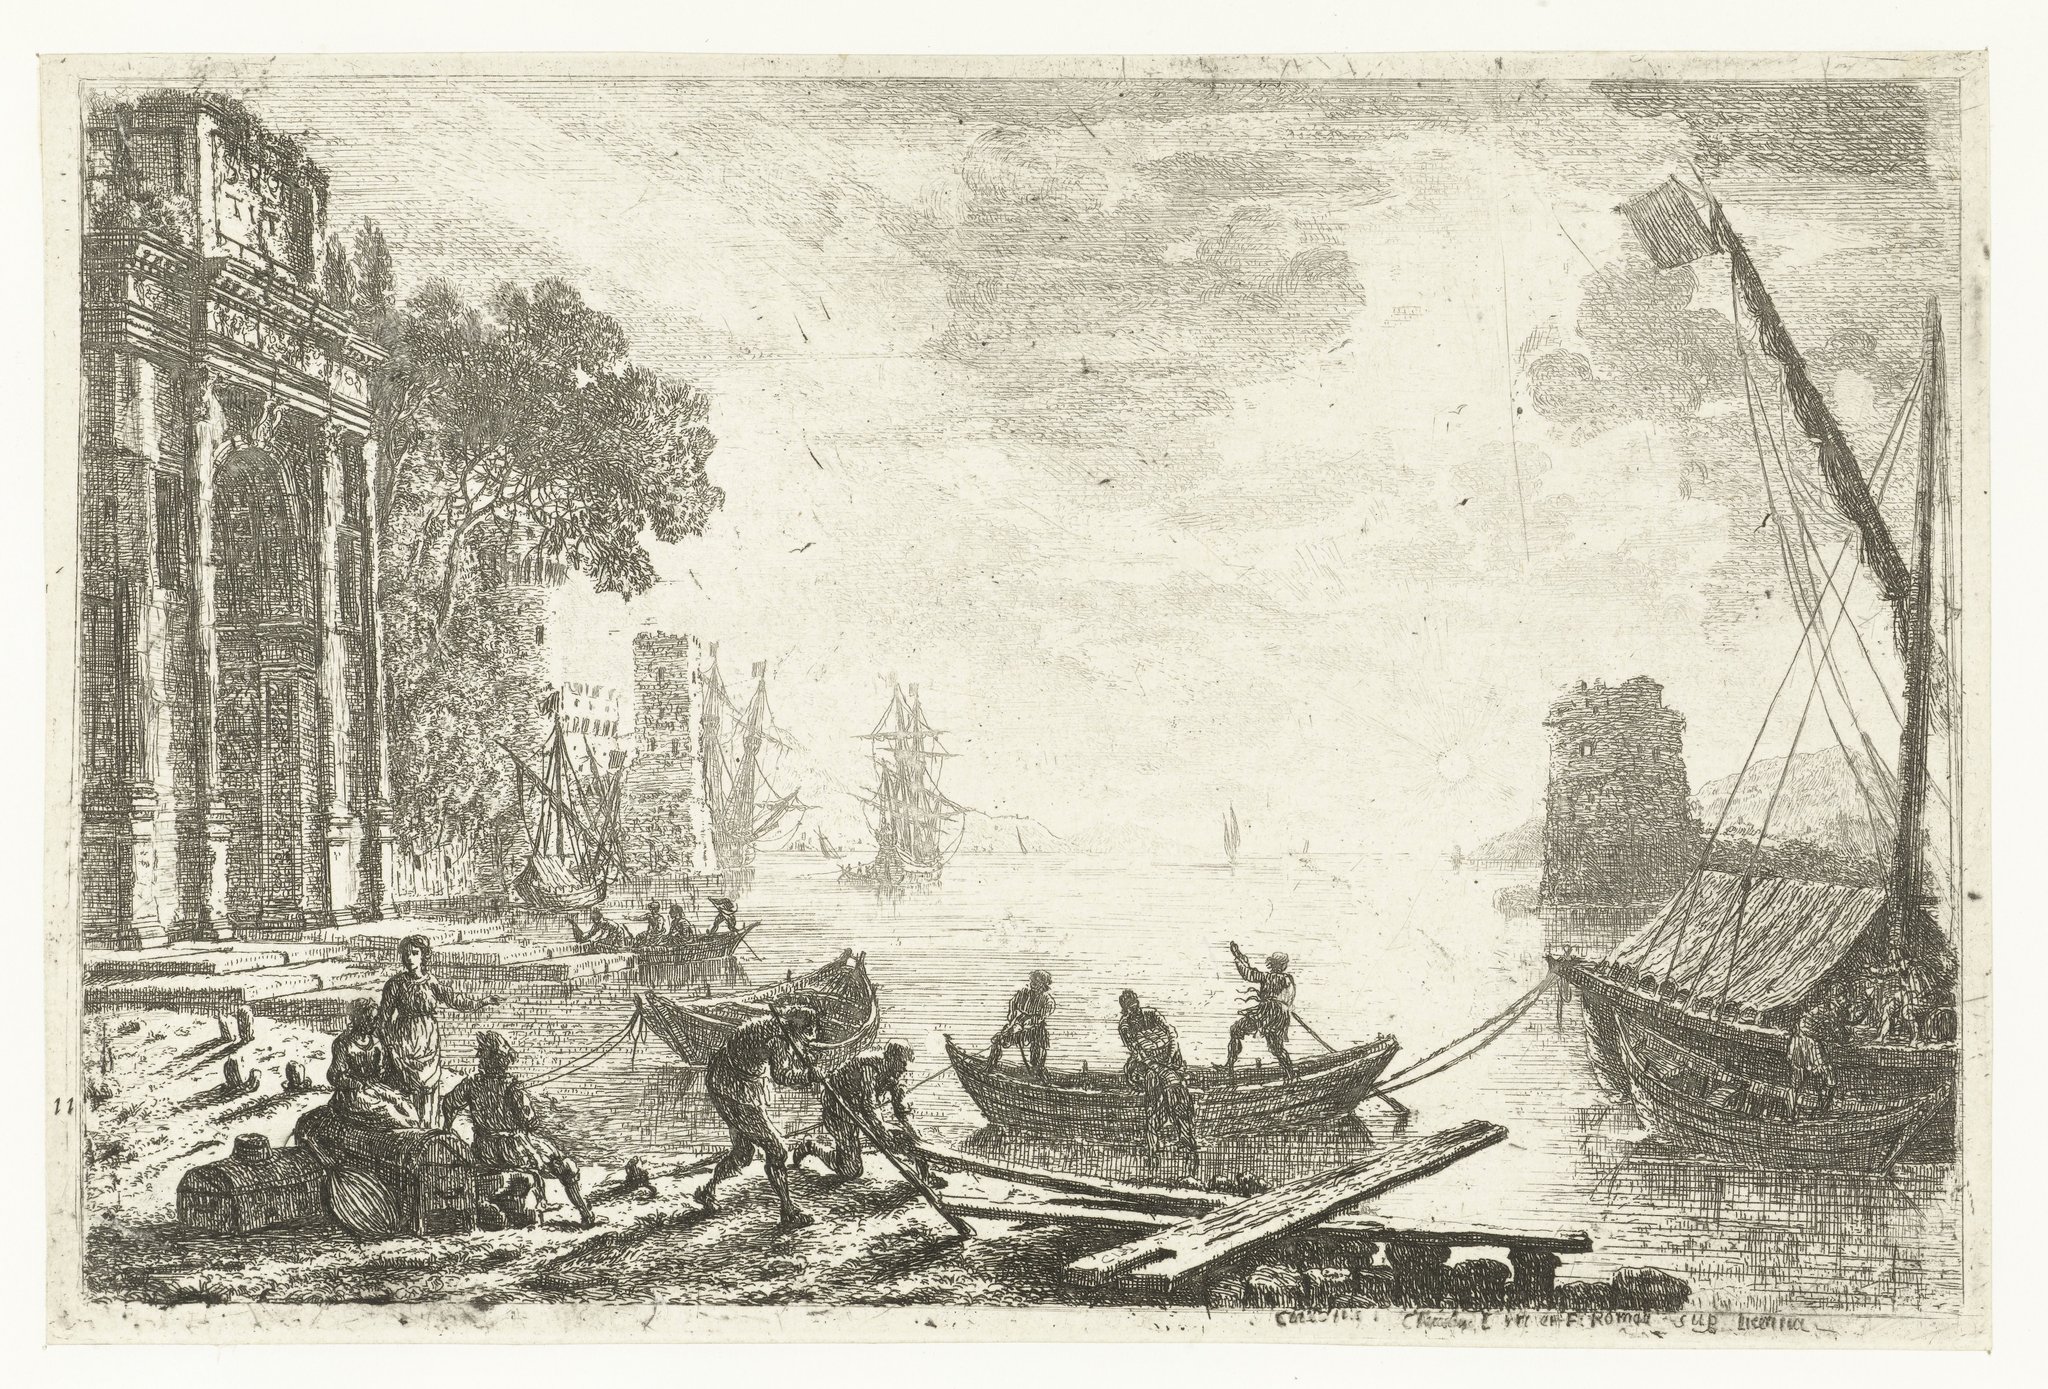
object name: print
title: Havenscène met opgaande zon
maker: claude lorrain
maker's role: draughtsman, print maker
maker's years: 1604-1682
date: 1634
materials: paper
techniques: etching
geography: rome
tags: harbour, 'en route', traveller under way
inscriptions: collector's mark: Lugt 240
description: Een havenpoort met aan elke zijde een toren, in de verte grote zeilschepen. In de haven een aantal kleine bootjes, op de kade een gezelschap met koffers.